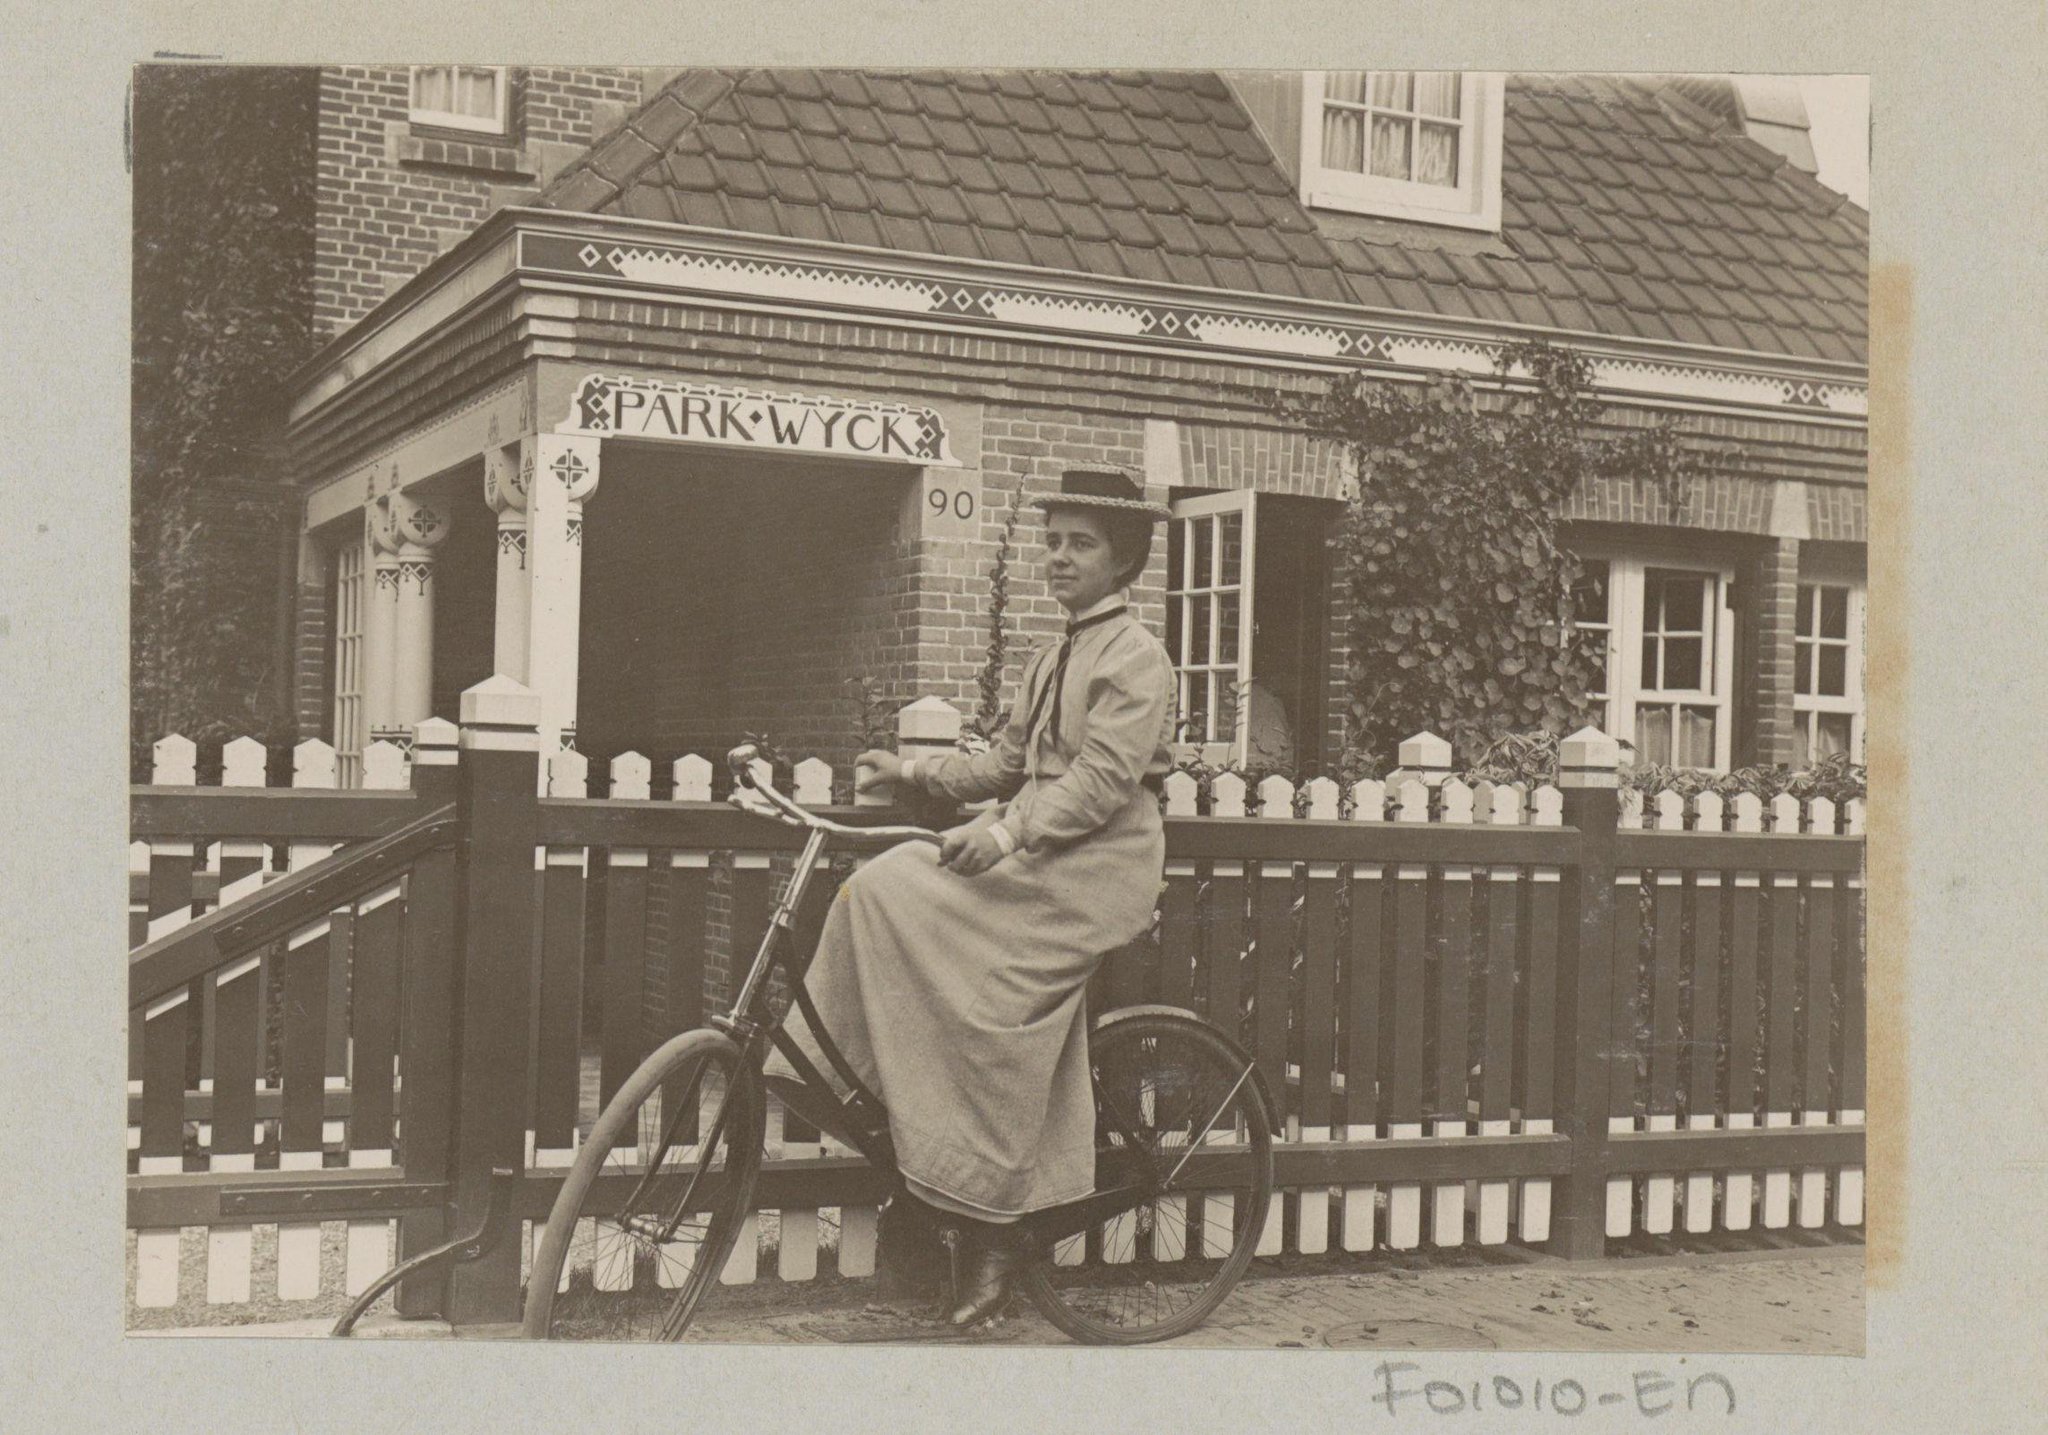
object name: photograph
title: Vrouw zittend op een fiets, leunend op een tuinhek van villa Parkwijck aan de Van Eeghenstraat 90 in Amsterdam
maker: Anonymous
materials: photographic support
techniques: matte daylight collodion silver print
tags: rural housing, e.g. country-house, villa, cottage, villa, bicycle, anonymous historical person portrayed - bb - woman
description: Villa Parkwyck, gelegen aan de Van Eeghenstraat 90 te Amsterdam, werd in 1900 gebouwd naar een ontwerp van architect H.P. Berlage in opdracht van L. Simons. Het huis werd in 1913 afgebroken en verplaatst naar de Soestdijksestraatweg 319 in Bilthoven.